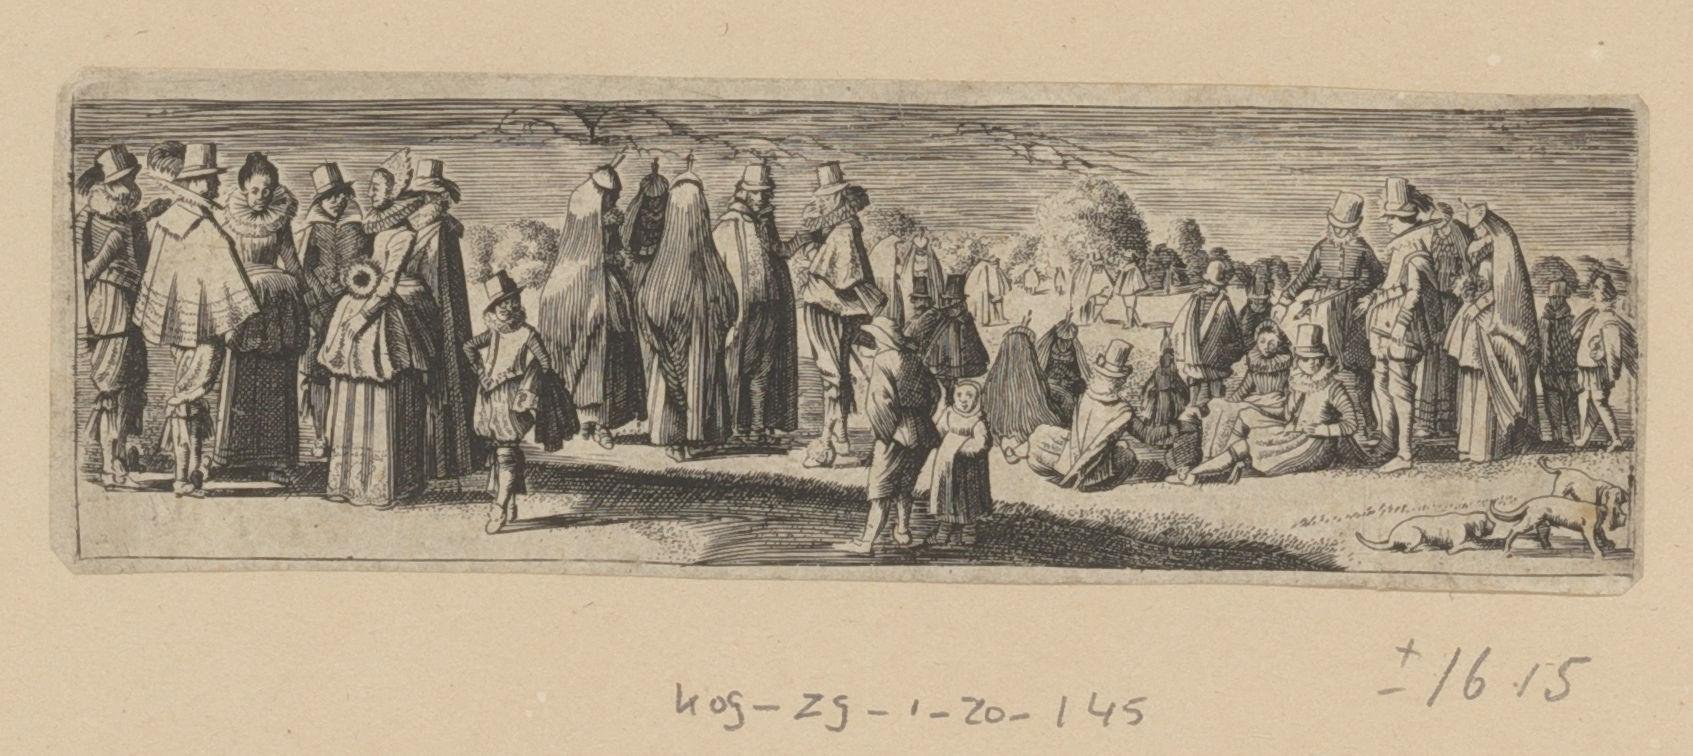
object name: print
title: Markt, kleine kopieën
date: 1603-1652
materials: paper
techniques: engraving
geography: amsterdam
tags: cape (huik) (+ women's clothes), open-air recreation, market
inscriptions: collector's mark: Lugt 1641, stamp, collector's mark, stamp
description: Elegante paren, staand en zittend op het gras, pratend met elkaar. Veel dames met huik. Rechtsonder op de voorgrond drie honden. Onderwerpsrubrieken binnen de Atlas Zeden en Gewoonten: Zeden en Gewoonten in Engeren Zin, De Kleeding, Kleederdrachten (tijdvakken), De eerste helft der 17de eeuw. (De Fransche mode).